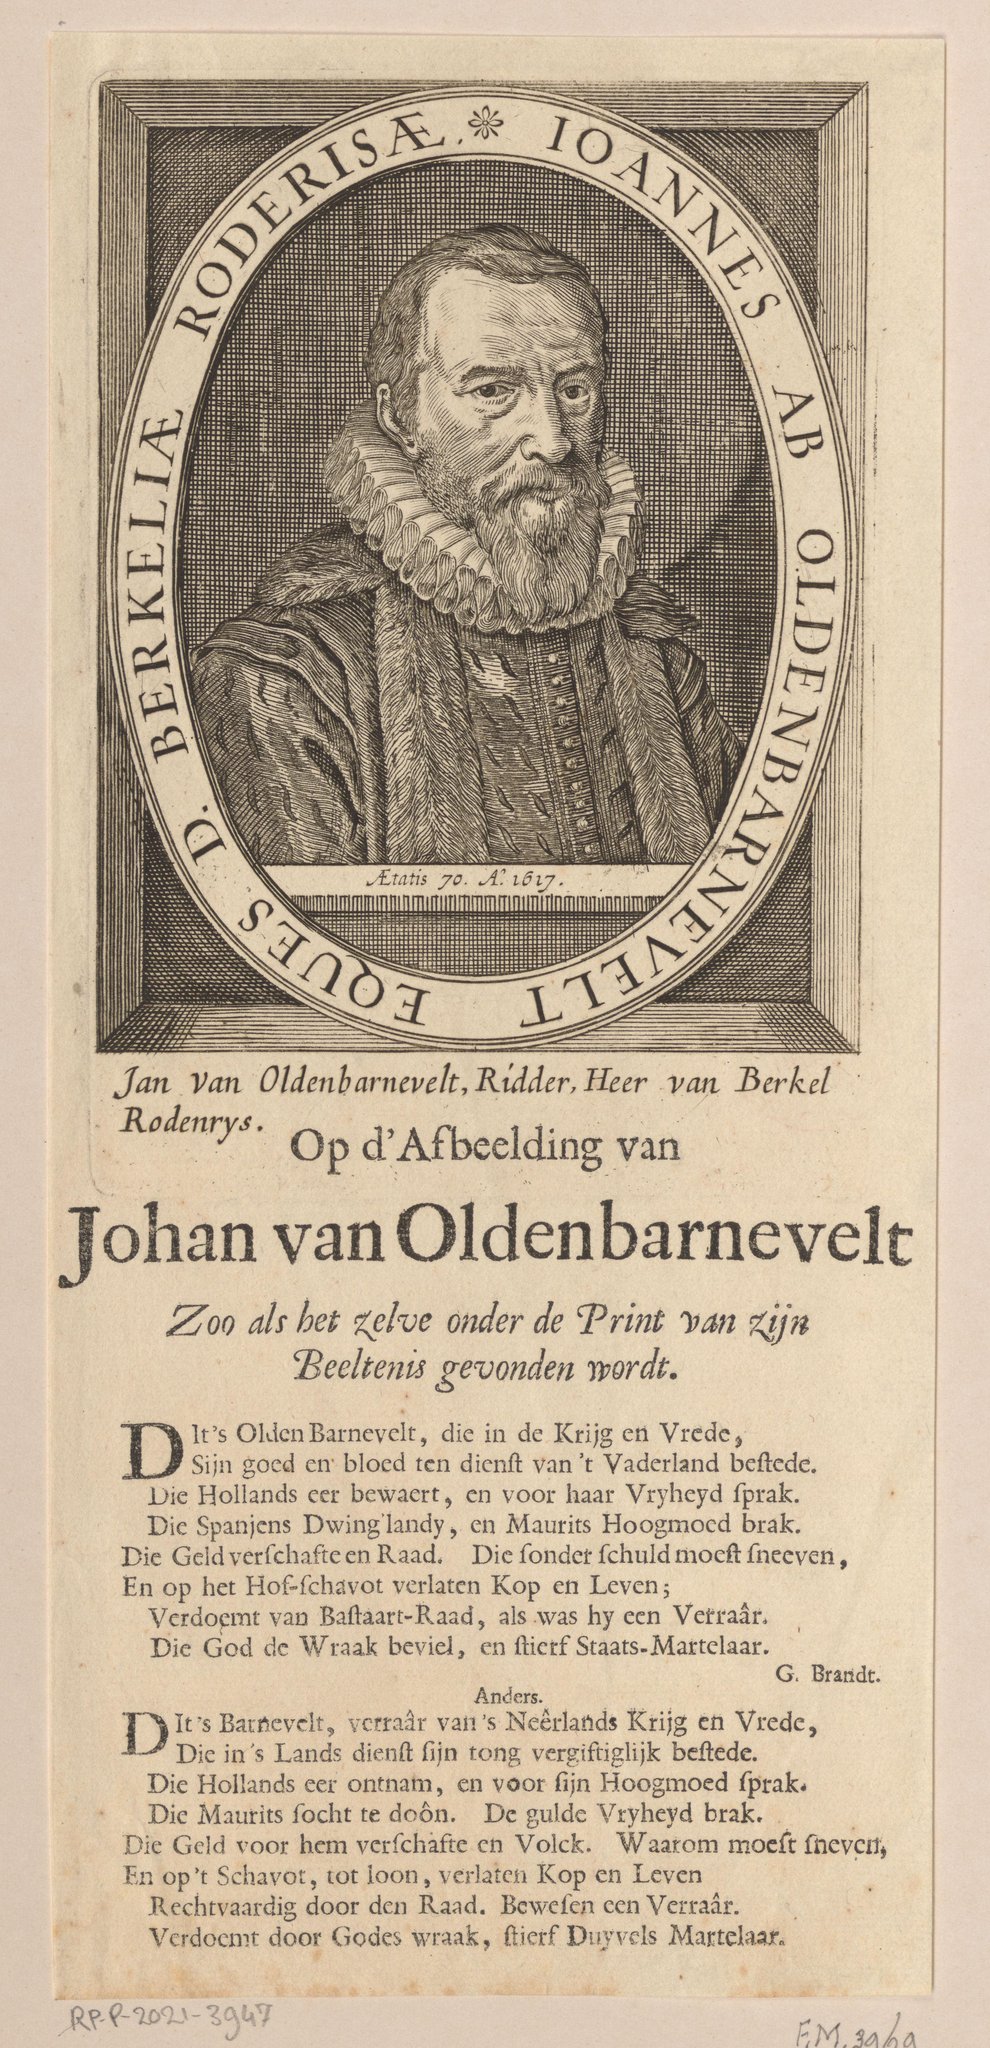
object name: print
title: Portret van Johan van Oldenbarnevelt op 70-jarige leeftijd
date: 1617-1699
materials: paper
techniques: engraving, letterpress printing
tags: johan van oldenbarnevelt, historical persons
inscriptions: collector's mark: Lugt 240